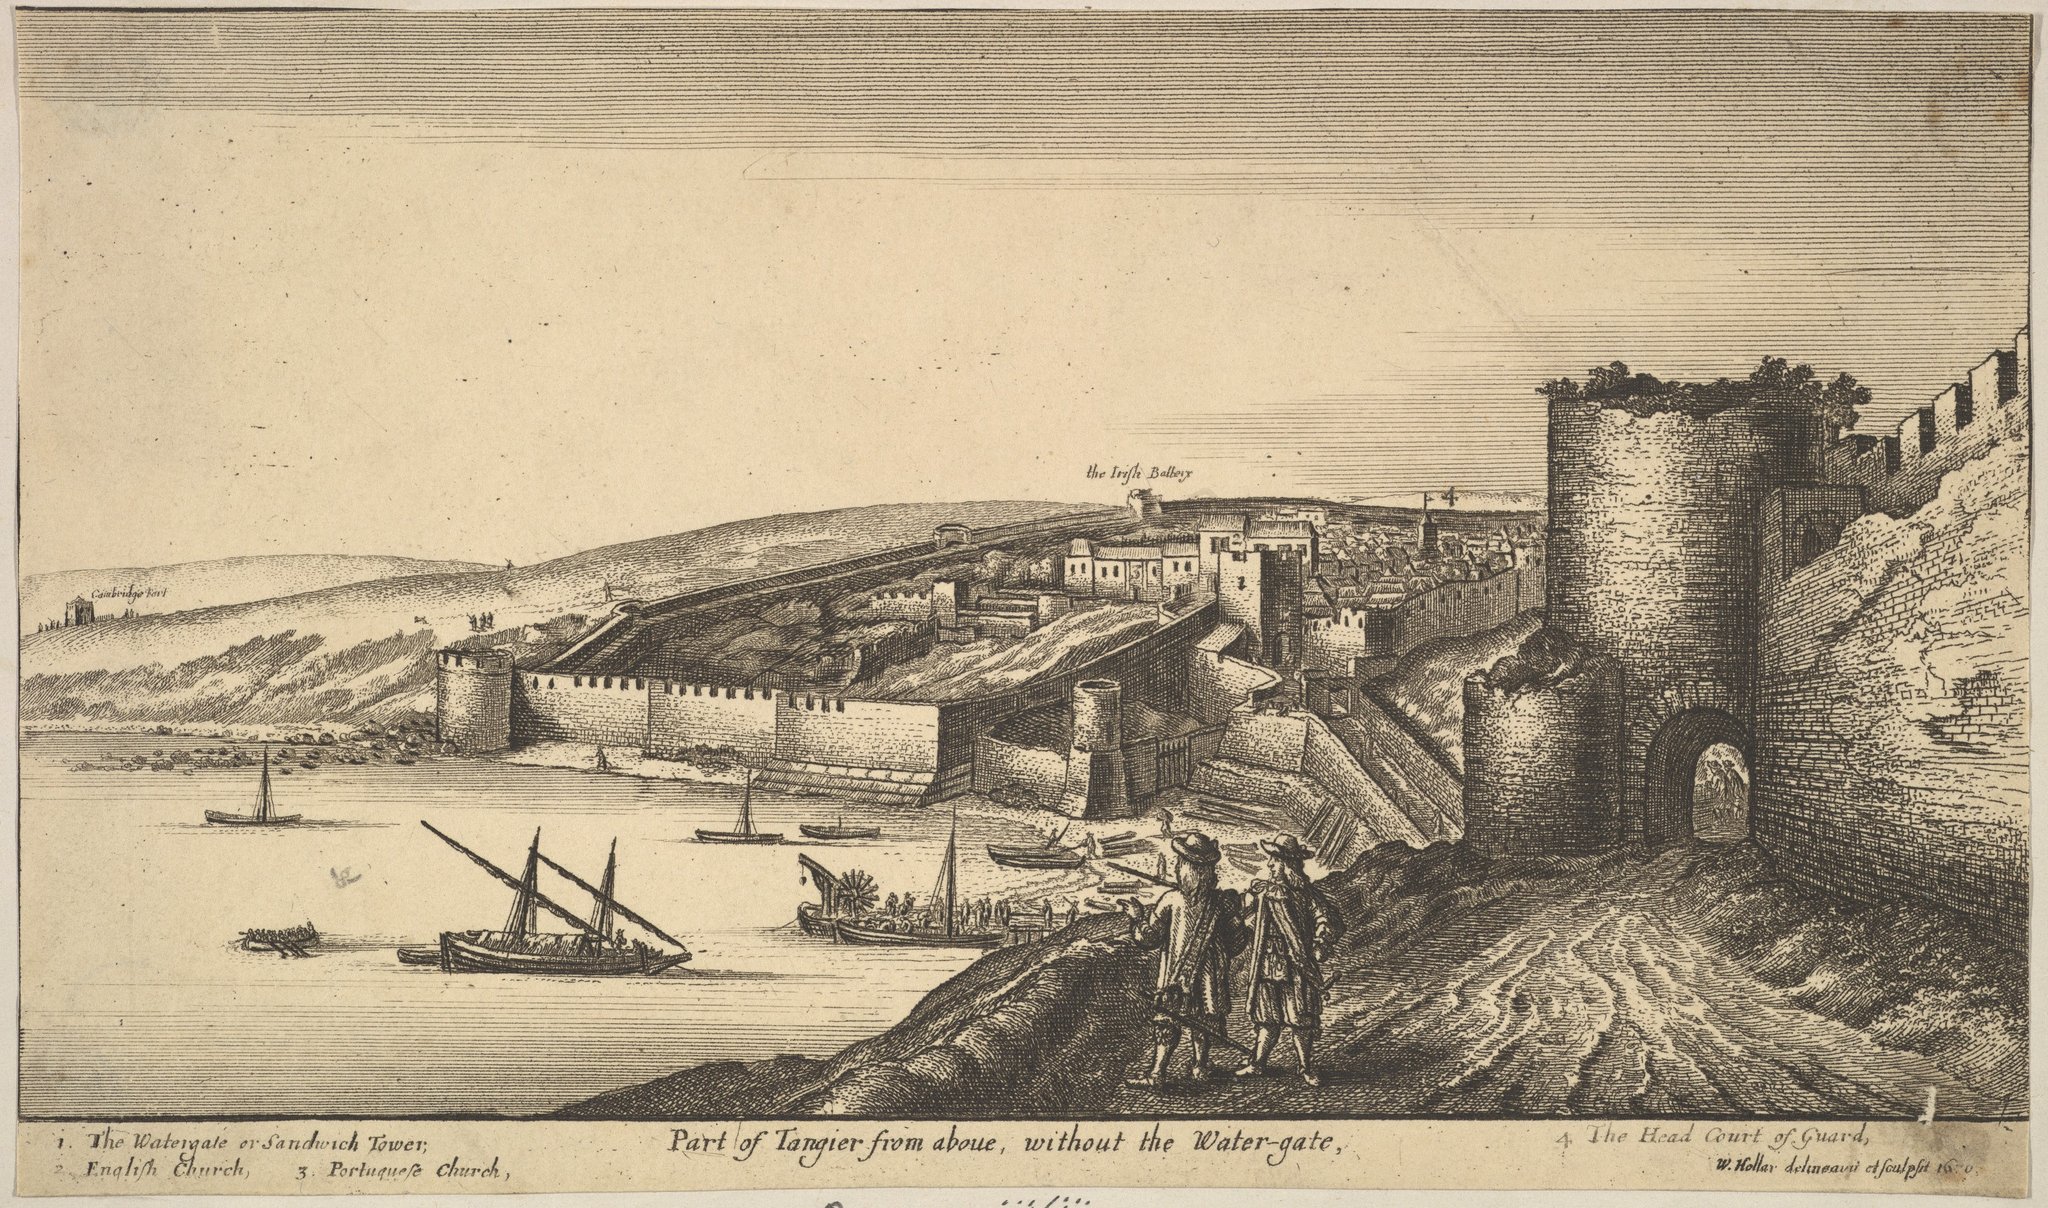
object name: print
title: Part of Tangier from above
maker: wenceslaus hollar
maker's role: artist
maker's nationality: bohemian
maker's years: 1607-1677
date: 1670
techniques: etching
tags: buildings,cities,ships